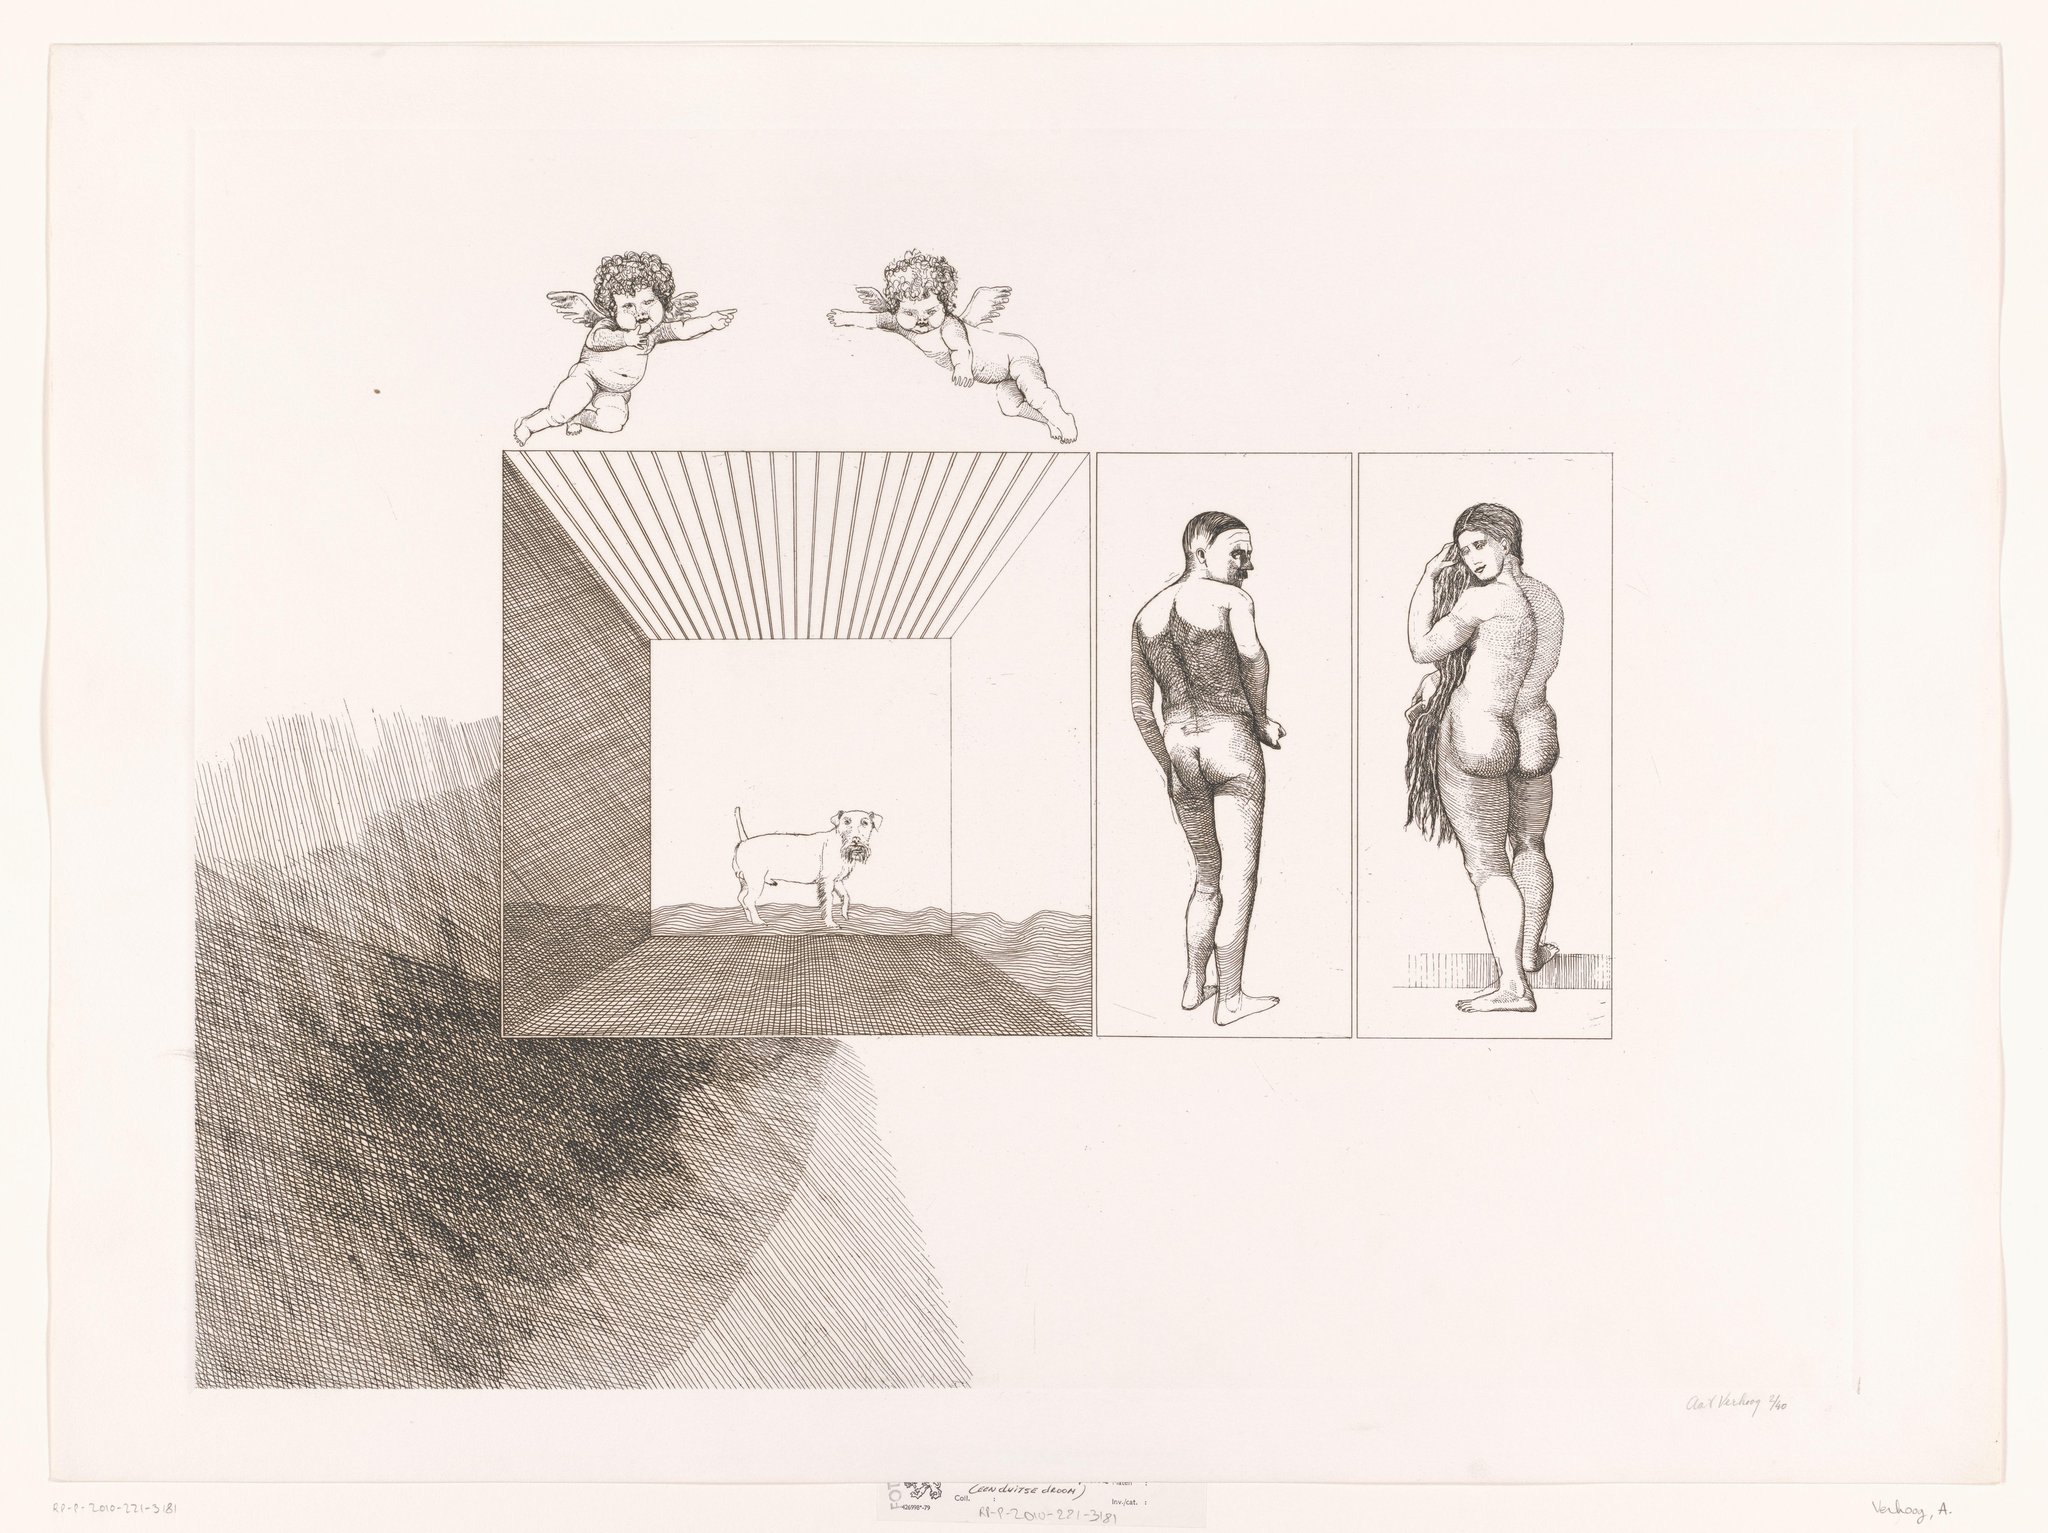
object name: print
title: Een leuke kleine hond (een Duitse droom)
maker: aat verhoog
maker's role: print maker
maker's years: 1933-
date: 1972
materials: paper, ink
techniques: etching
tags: dog, germany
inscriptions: signature: ‘Aat Verhoog’, edition: ‘2/40’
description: Hond met een snor in een kubus met daarboven twee vliegende cherubijnen en rechts twee rechthoeken met daarin een naakte man [Hitler?] en een naakte vrouw op de rug gezien.